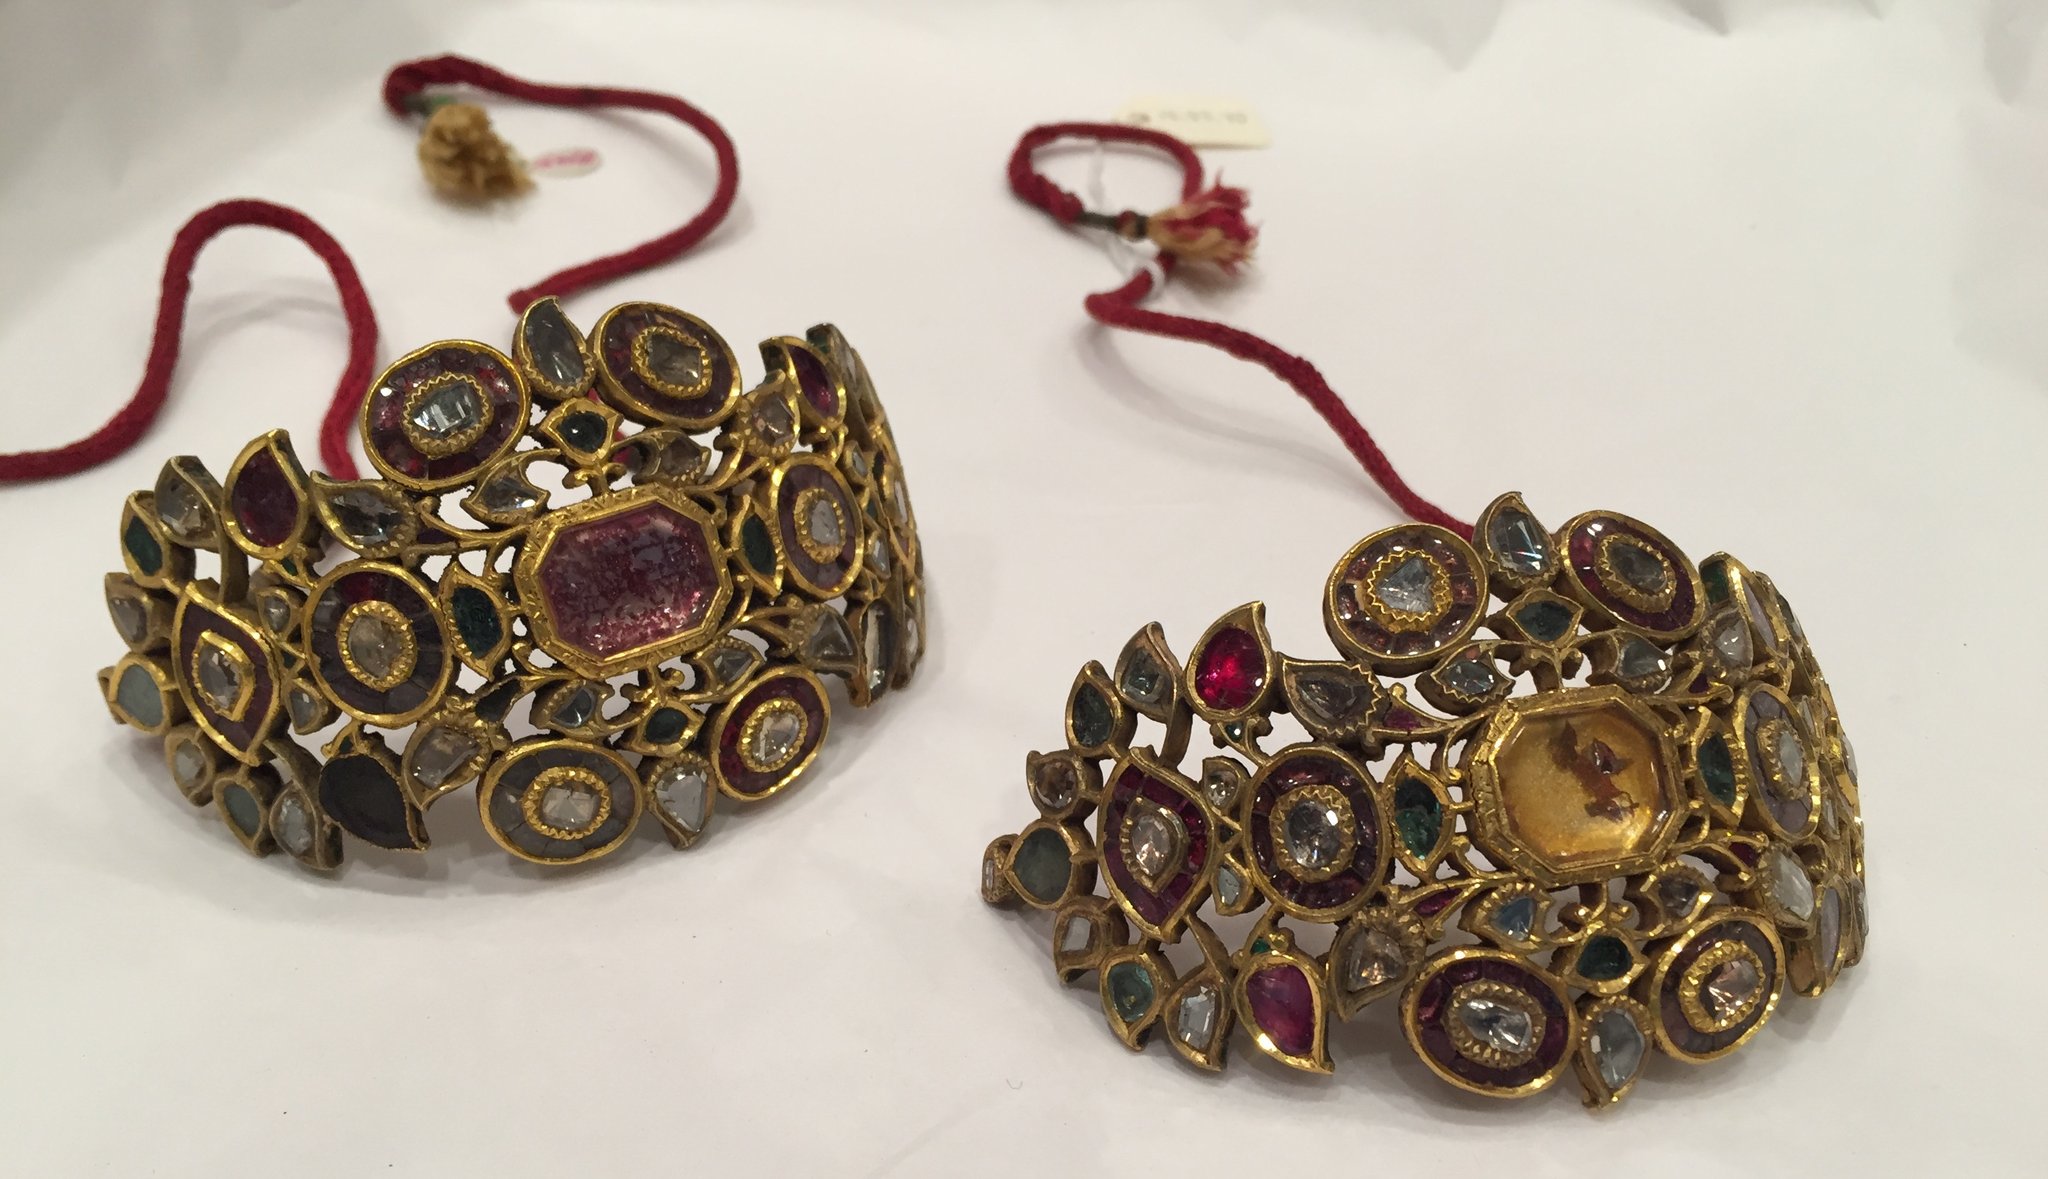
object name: armband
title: Armband (Bazuband), One of a Pair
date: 1801-1900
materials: enamel, gold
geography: india